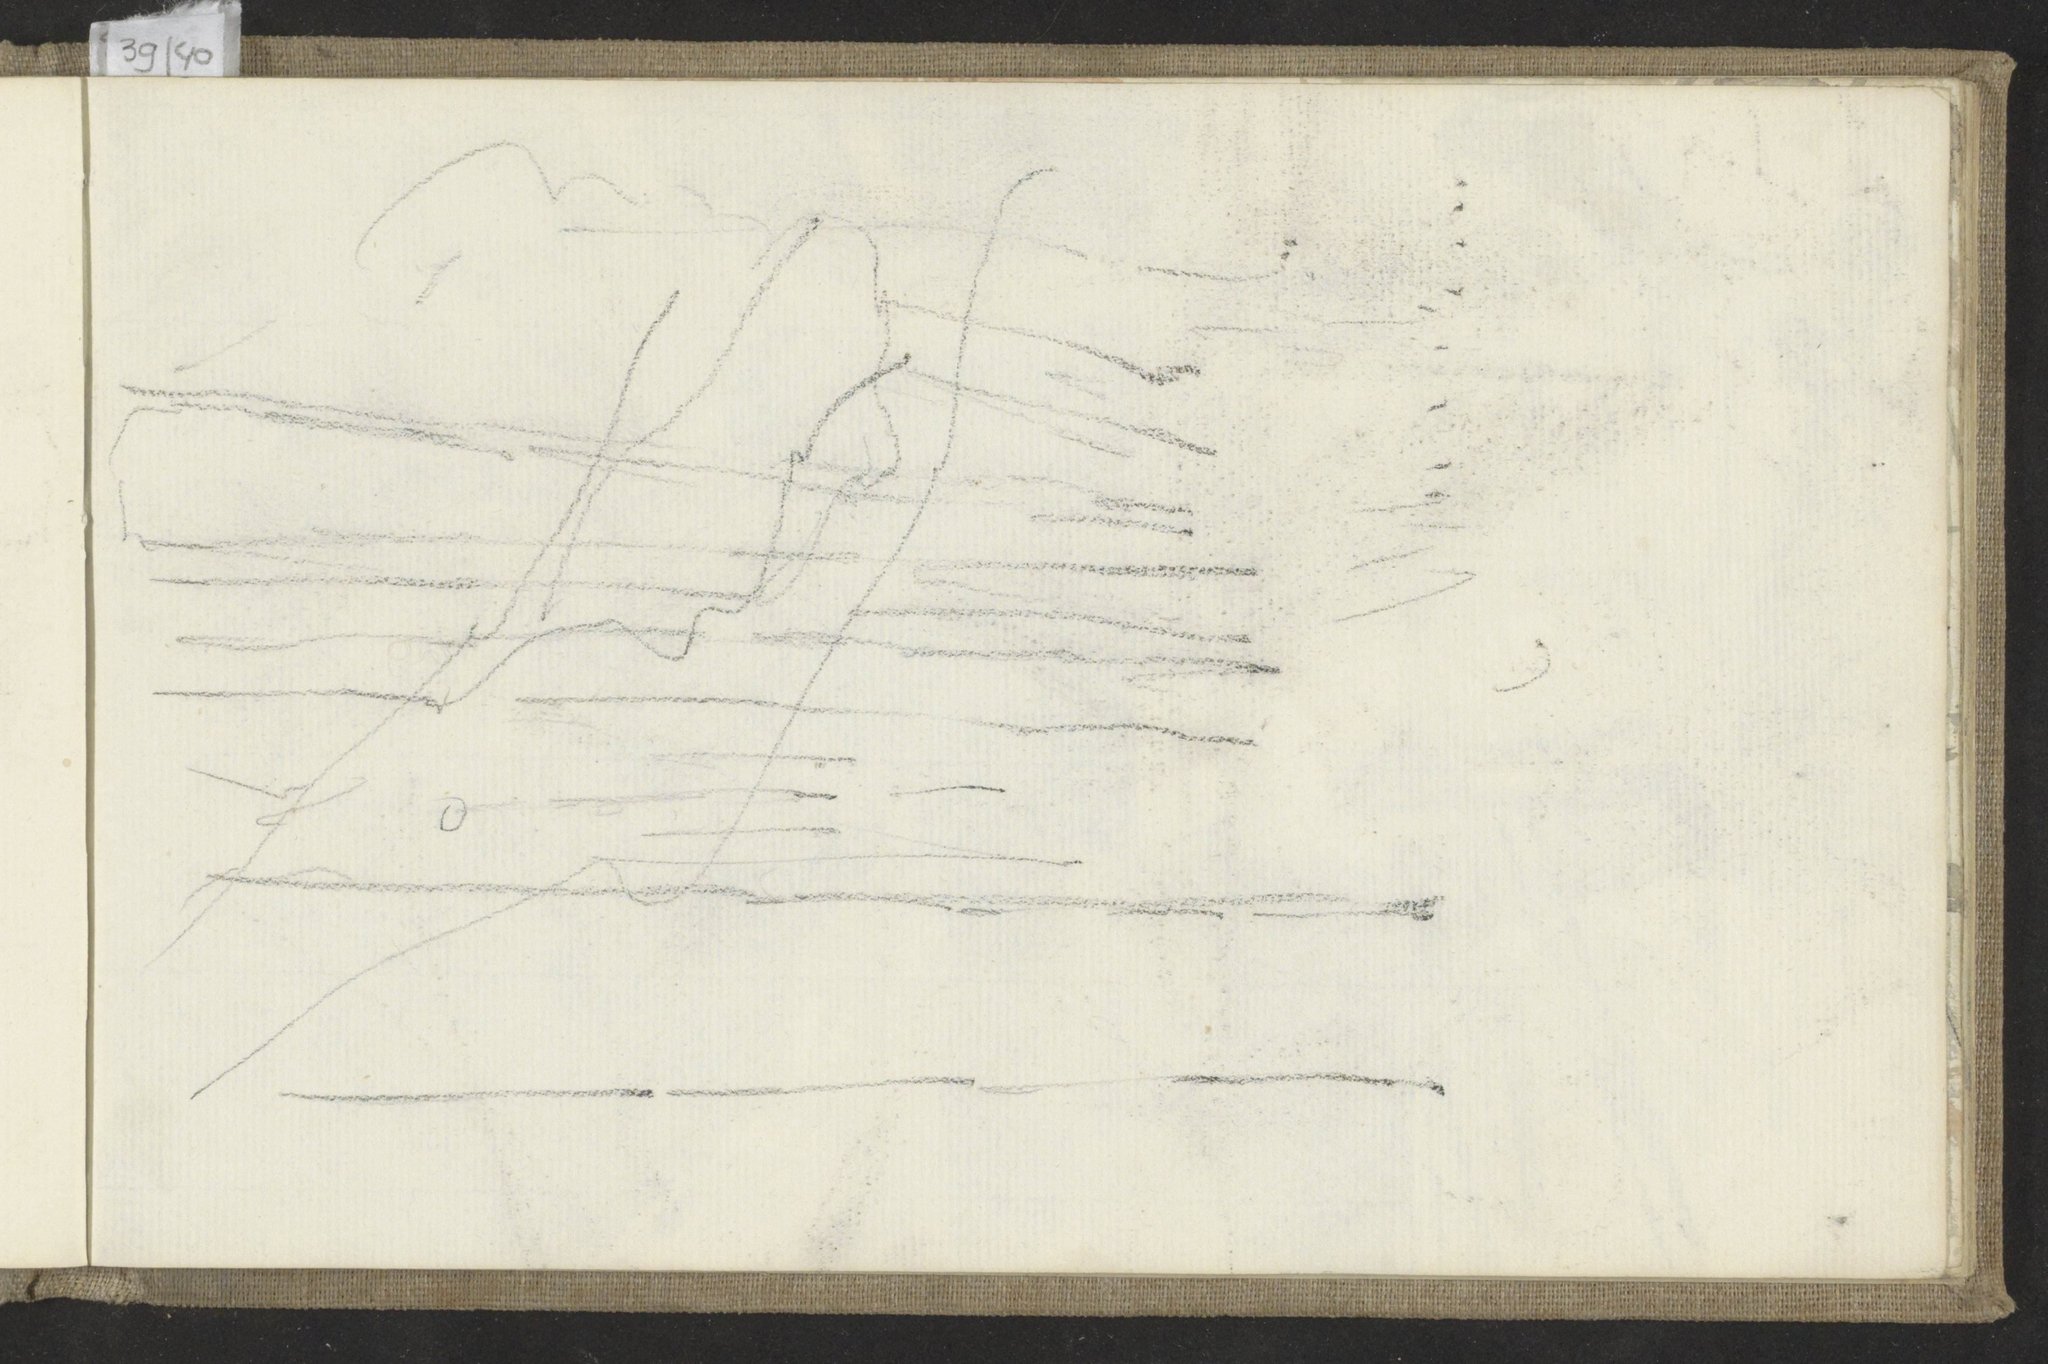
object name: sketchbook leaf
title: Studie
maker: jonkheer johannes ludovicus paulus bosch van drakestein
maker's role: draughtsman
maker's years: 1865-1929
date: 1896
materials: paper, pencil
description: Blad 35 recto uit een schetsboek met 58 bladen.